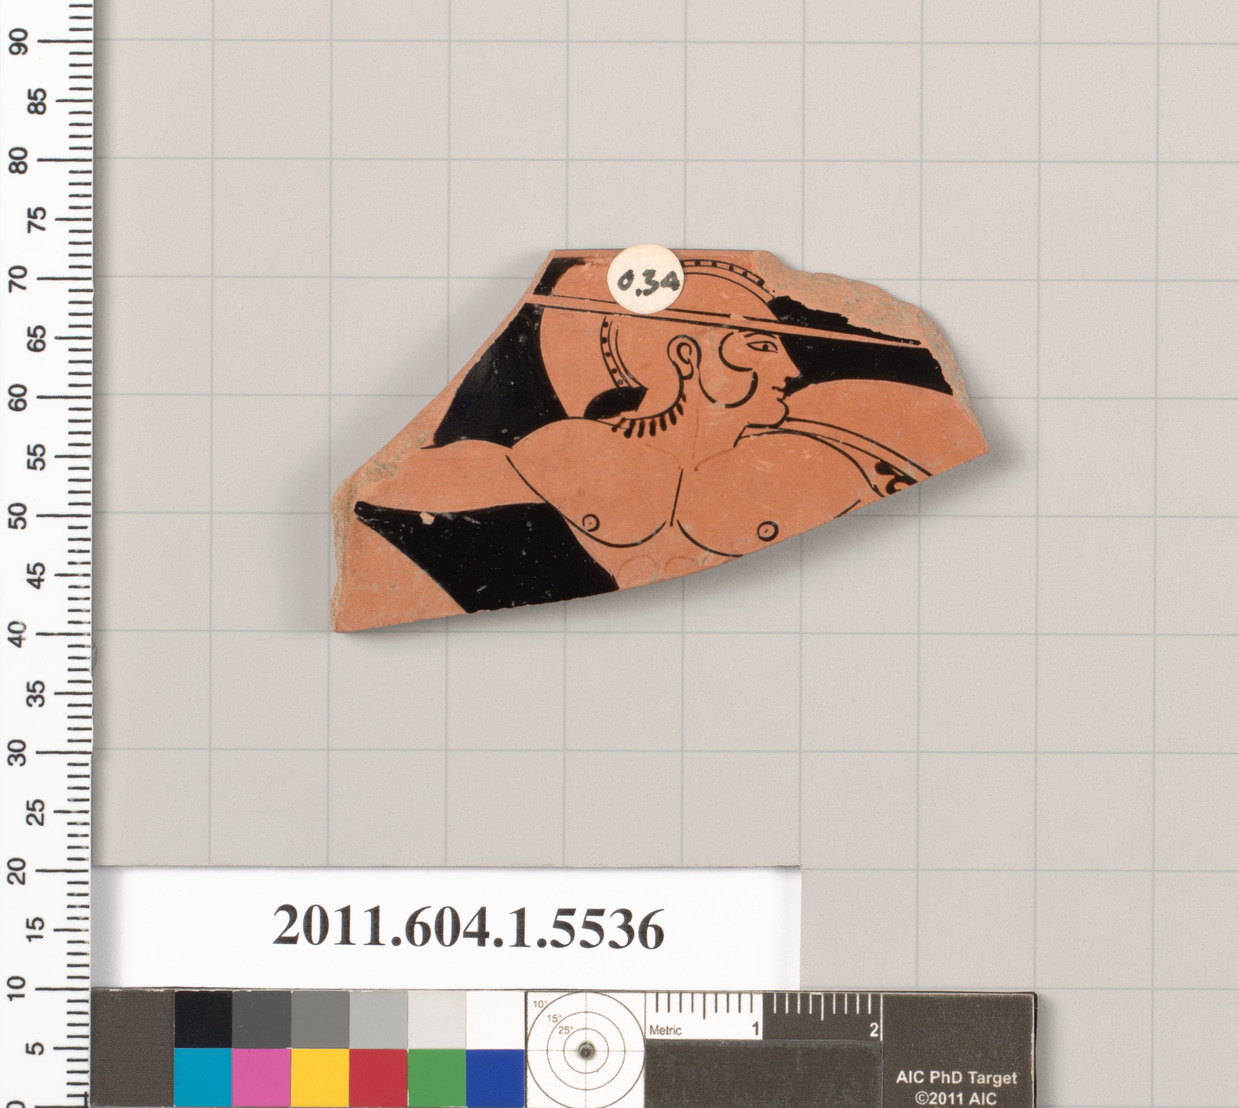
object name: kylix fragment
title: Terracotta rim fragment of a kylix (drinking cup)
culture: greek, attic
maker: bonn painter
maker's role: artist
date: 500-480 BCE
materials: terracotta